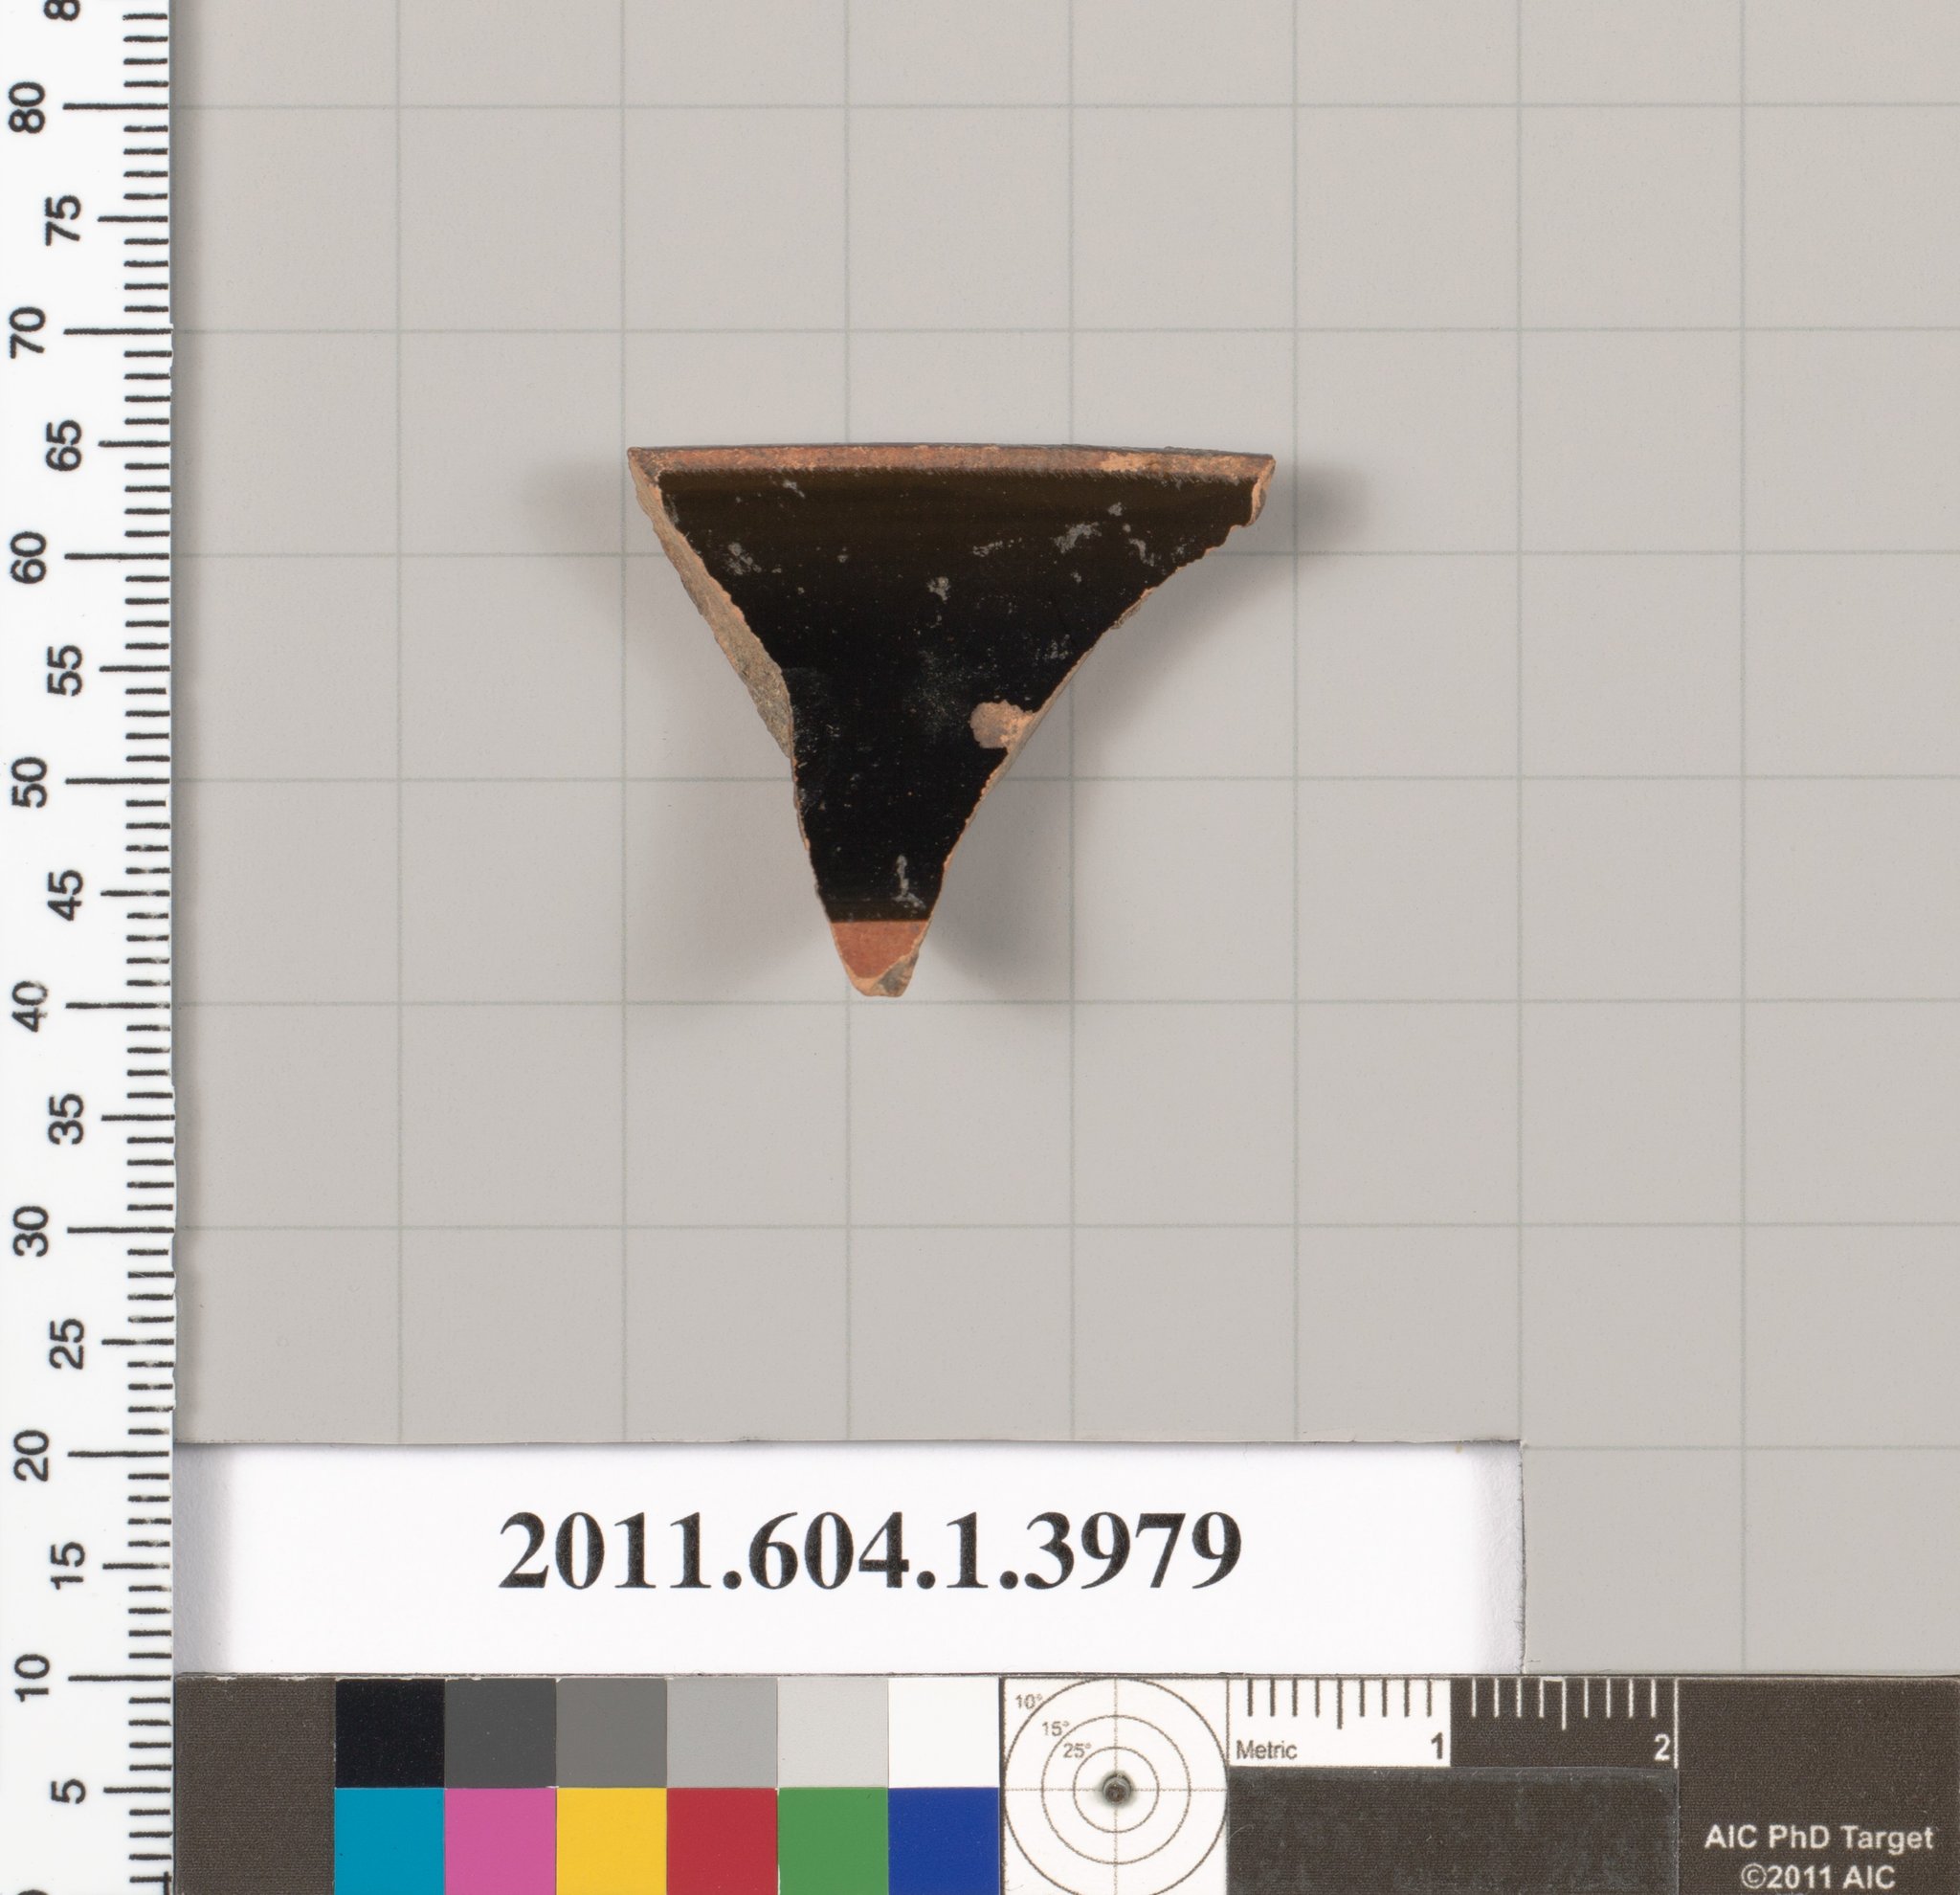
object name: kylix fragment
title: Terracotta rim fragment of a kylix (drinking cup)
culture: greek, attic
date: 475-451 BCE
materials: terracotta